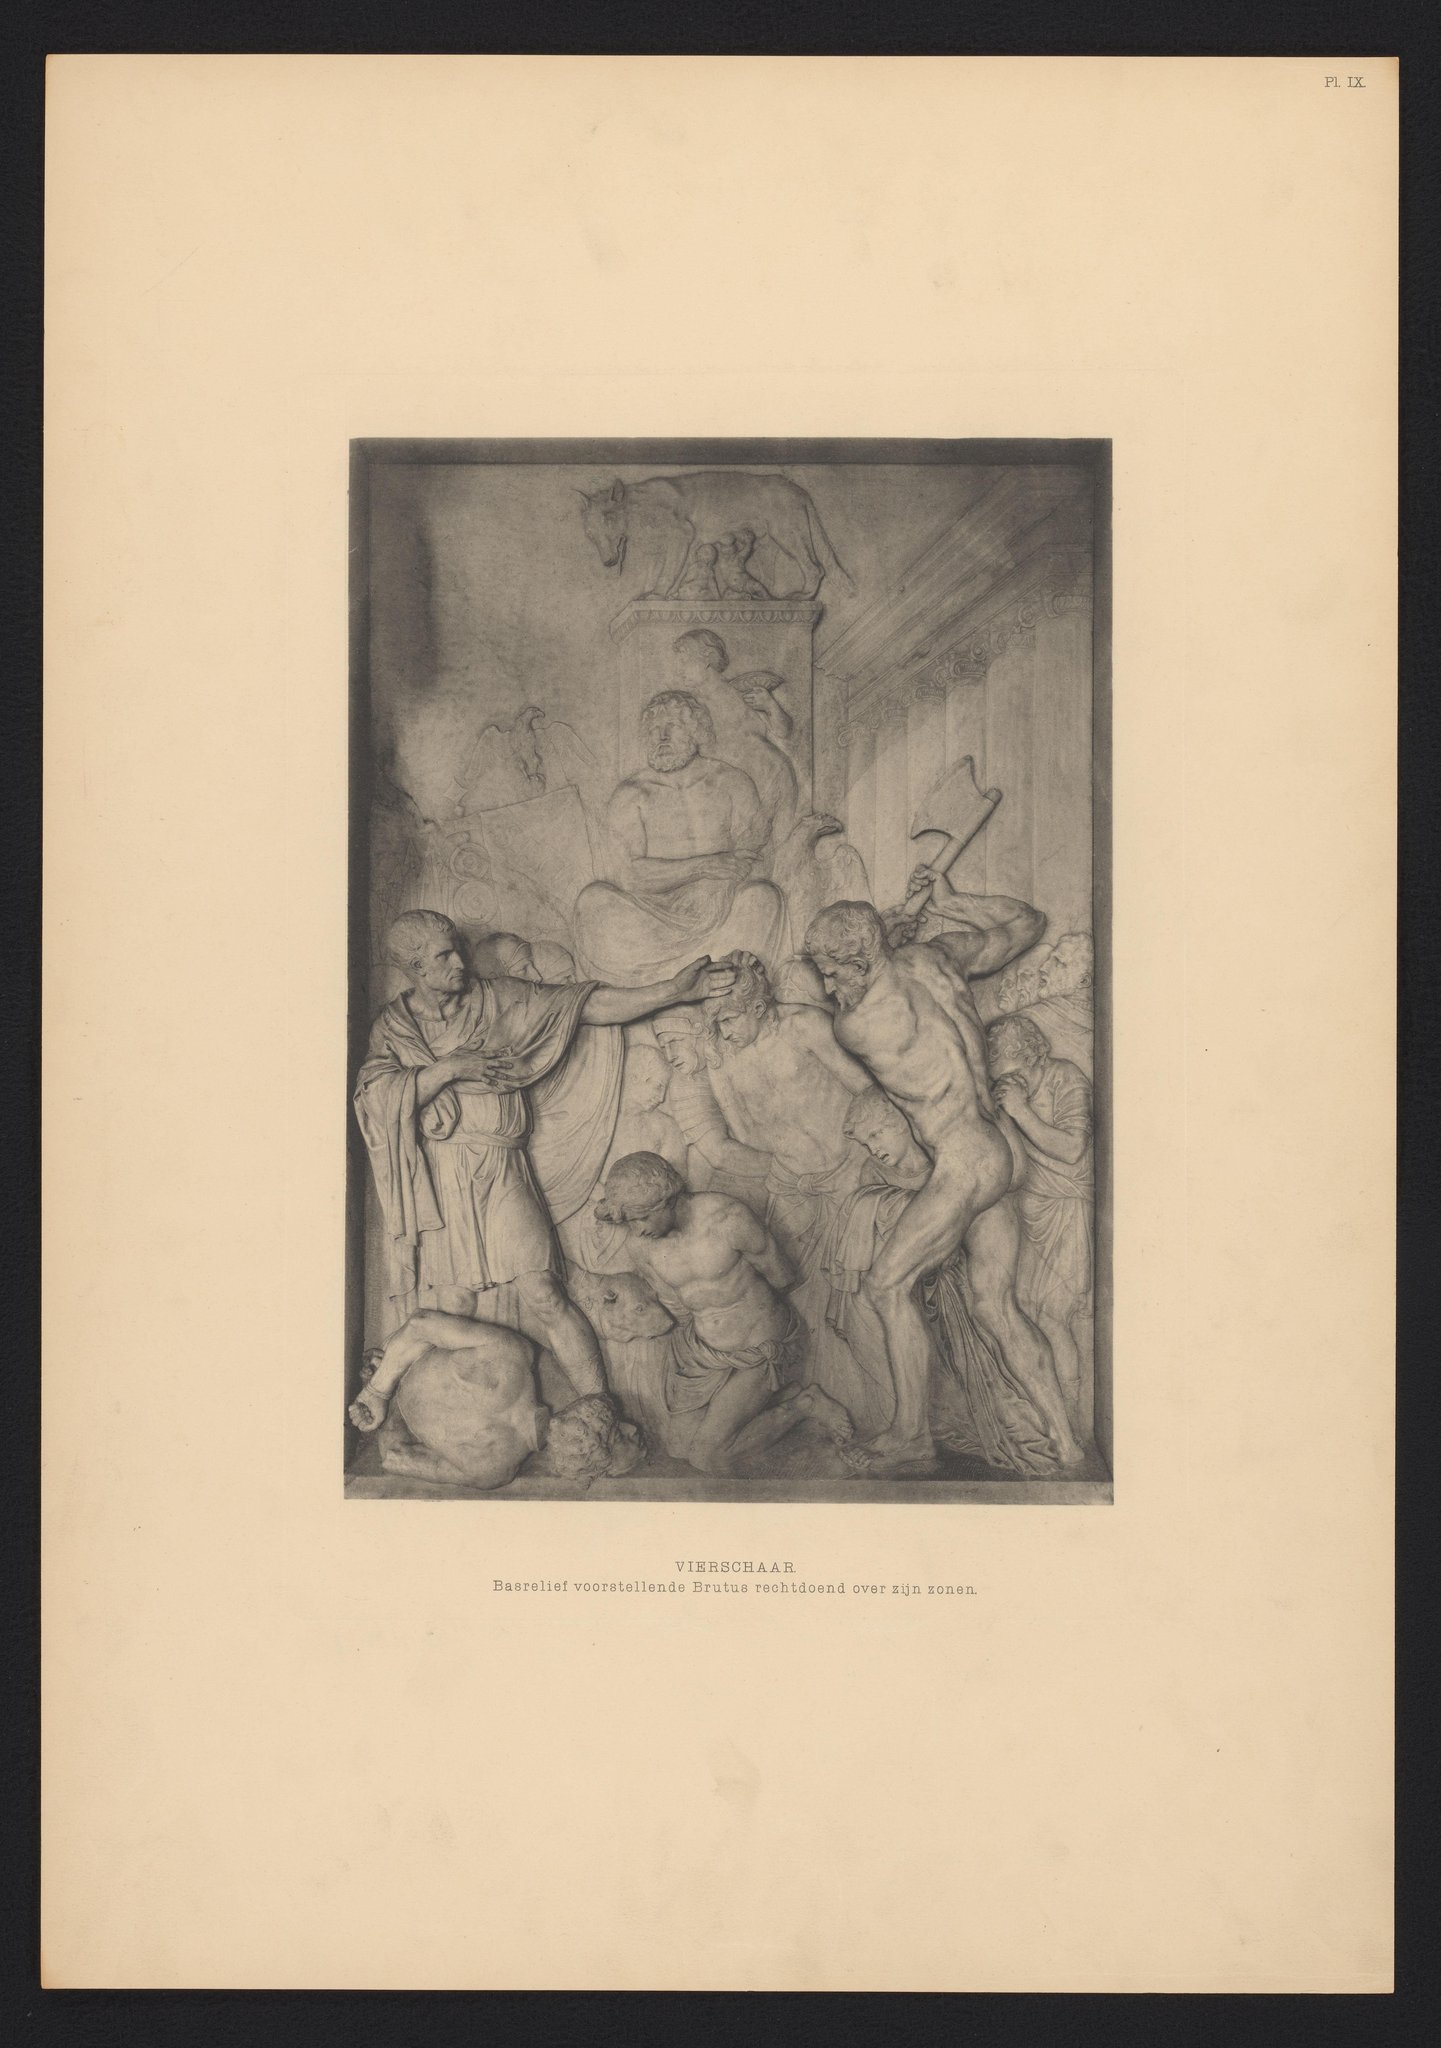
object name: fotomechanisch procedé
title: C.T.J. Louis Rieber, Het Koninklijk Paleis te Amsterdam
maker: Anonymous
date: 1899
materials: cardboard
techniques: photograph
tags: palace, piece of sculpture, reproduction of a piece of sculpture, royal palace of amsterdam, amsterdam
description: Vierschaar. Basrelief voorstellende Brutus rechtdoend over zijn zonen.